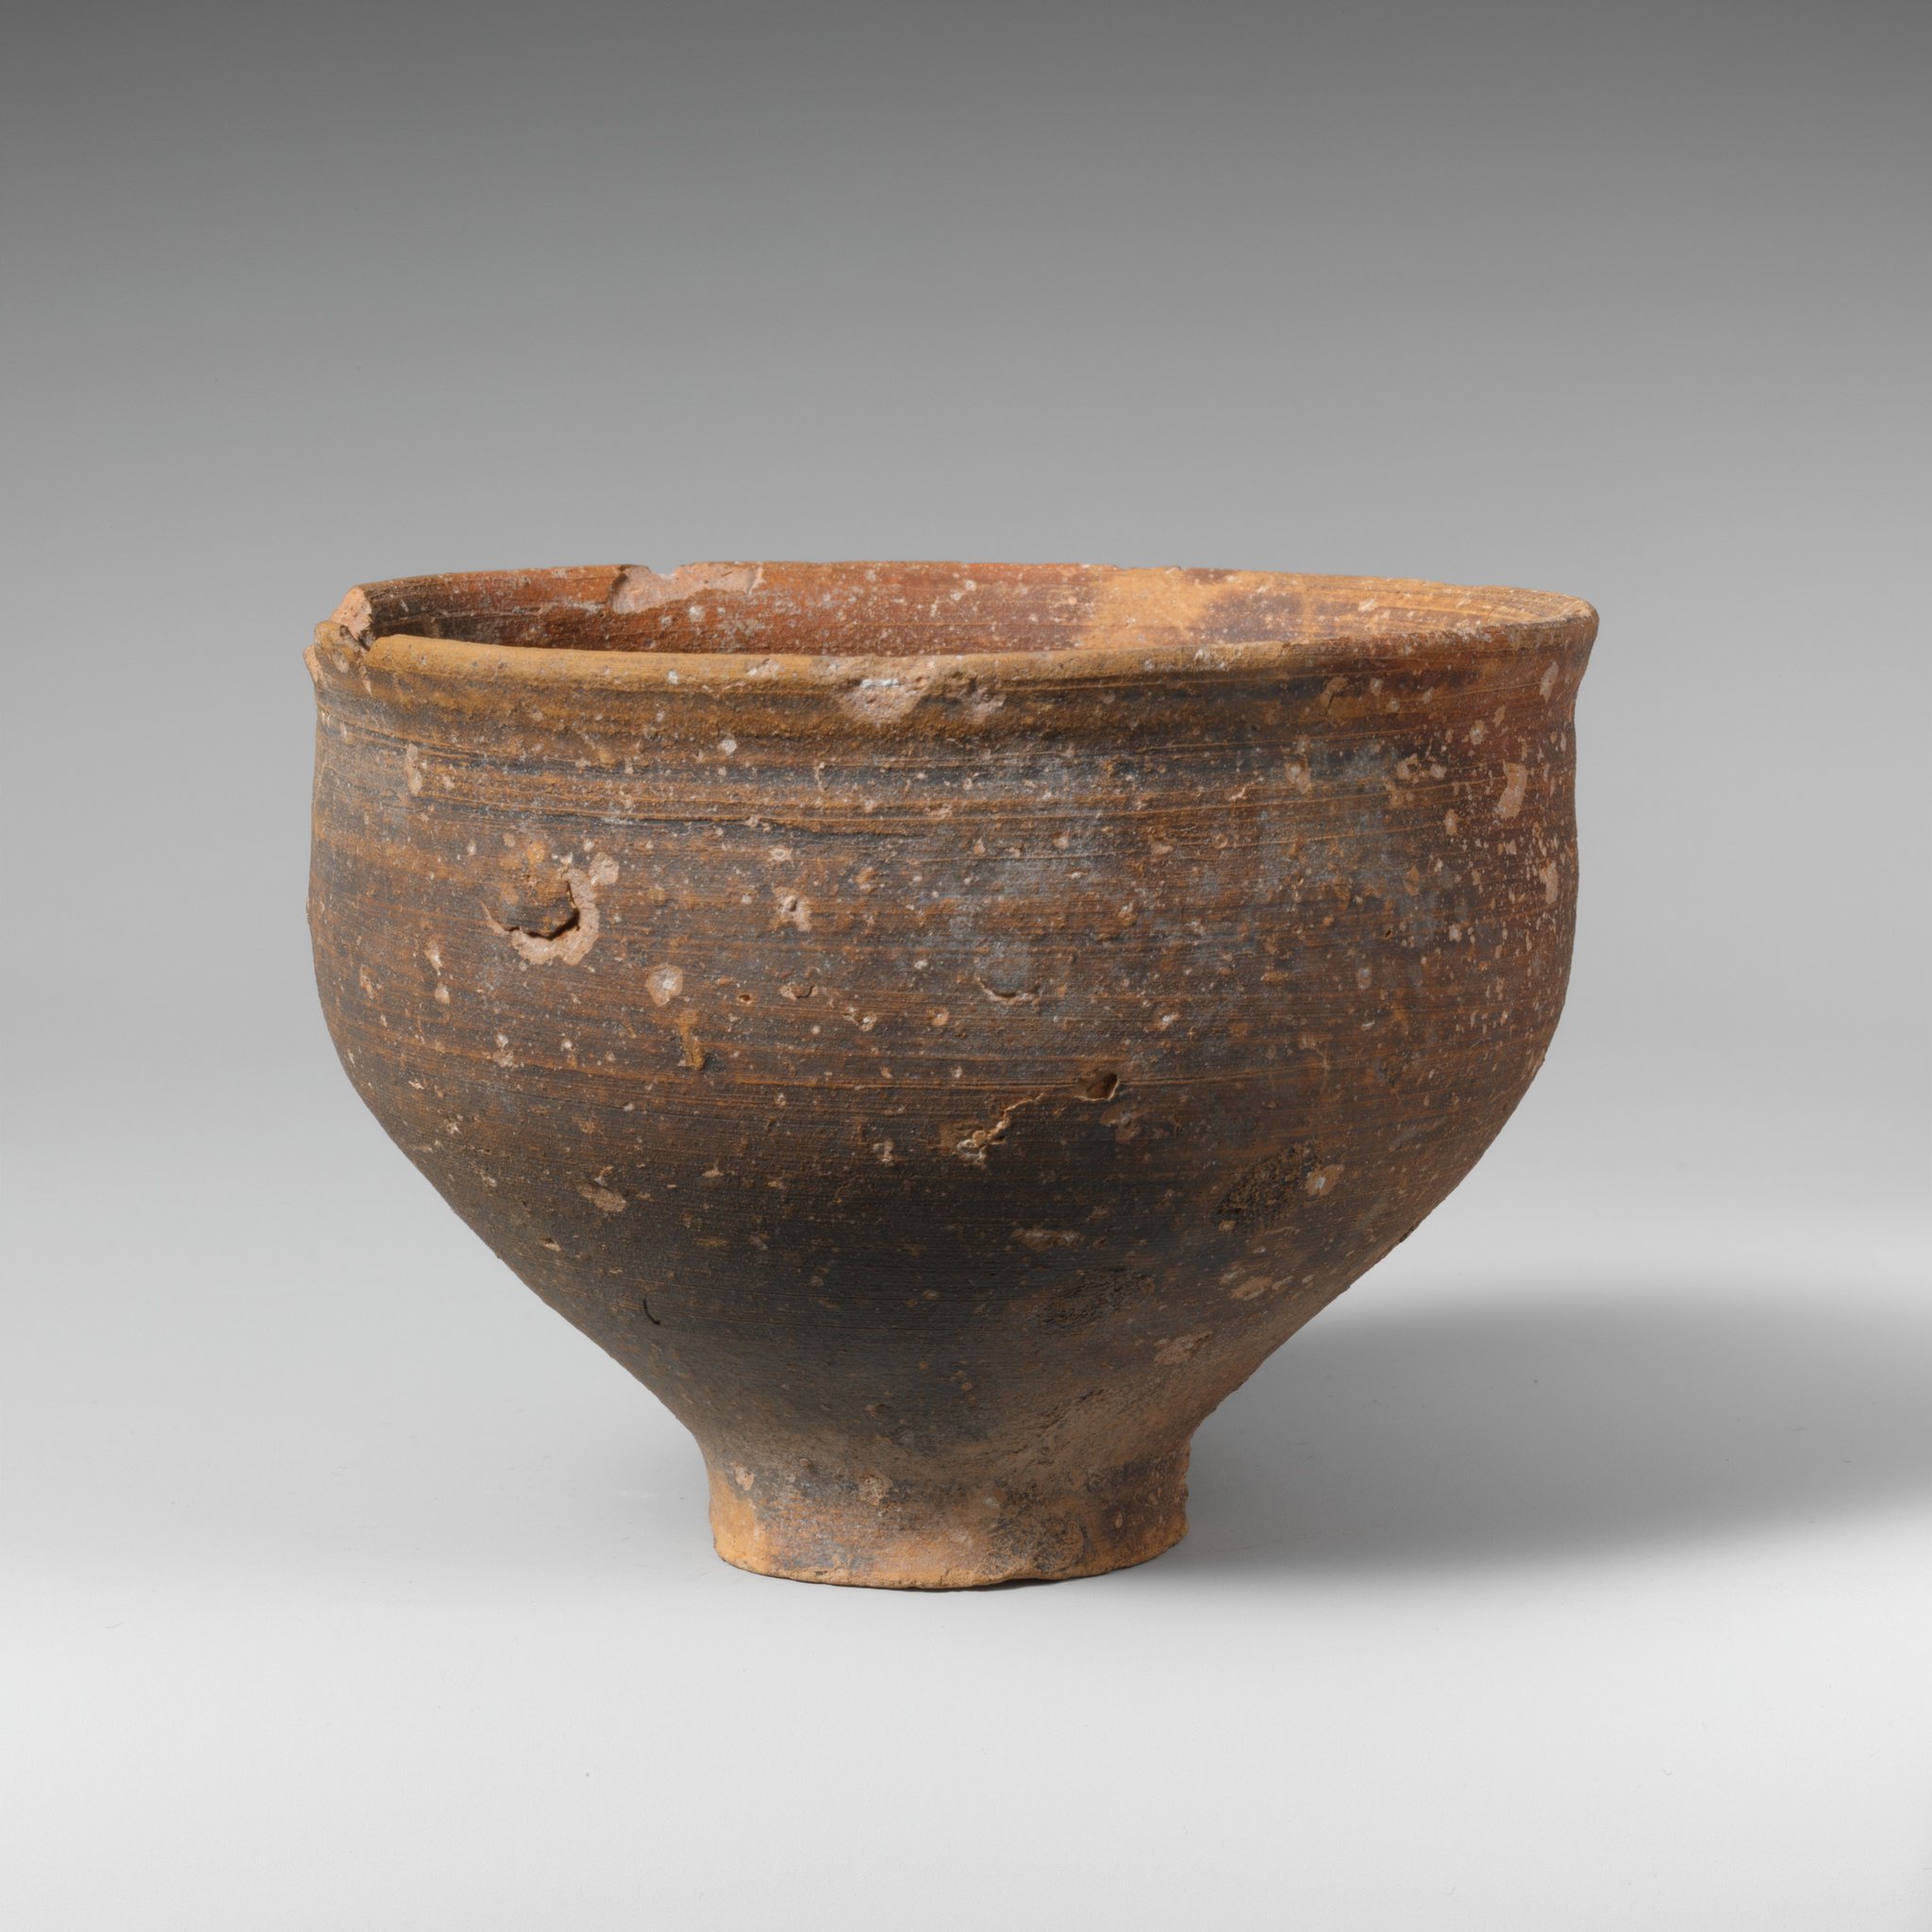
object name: bowl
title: Terracotta bowl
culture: minoan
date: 1500-1450 BCE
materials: terracotta